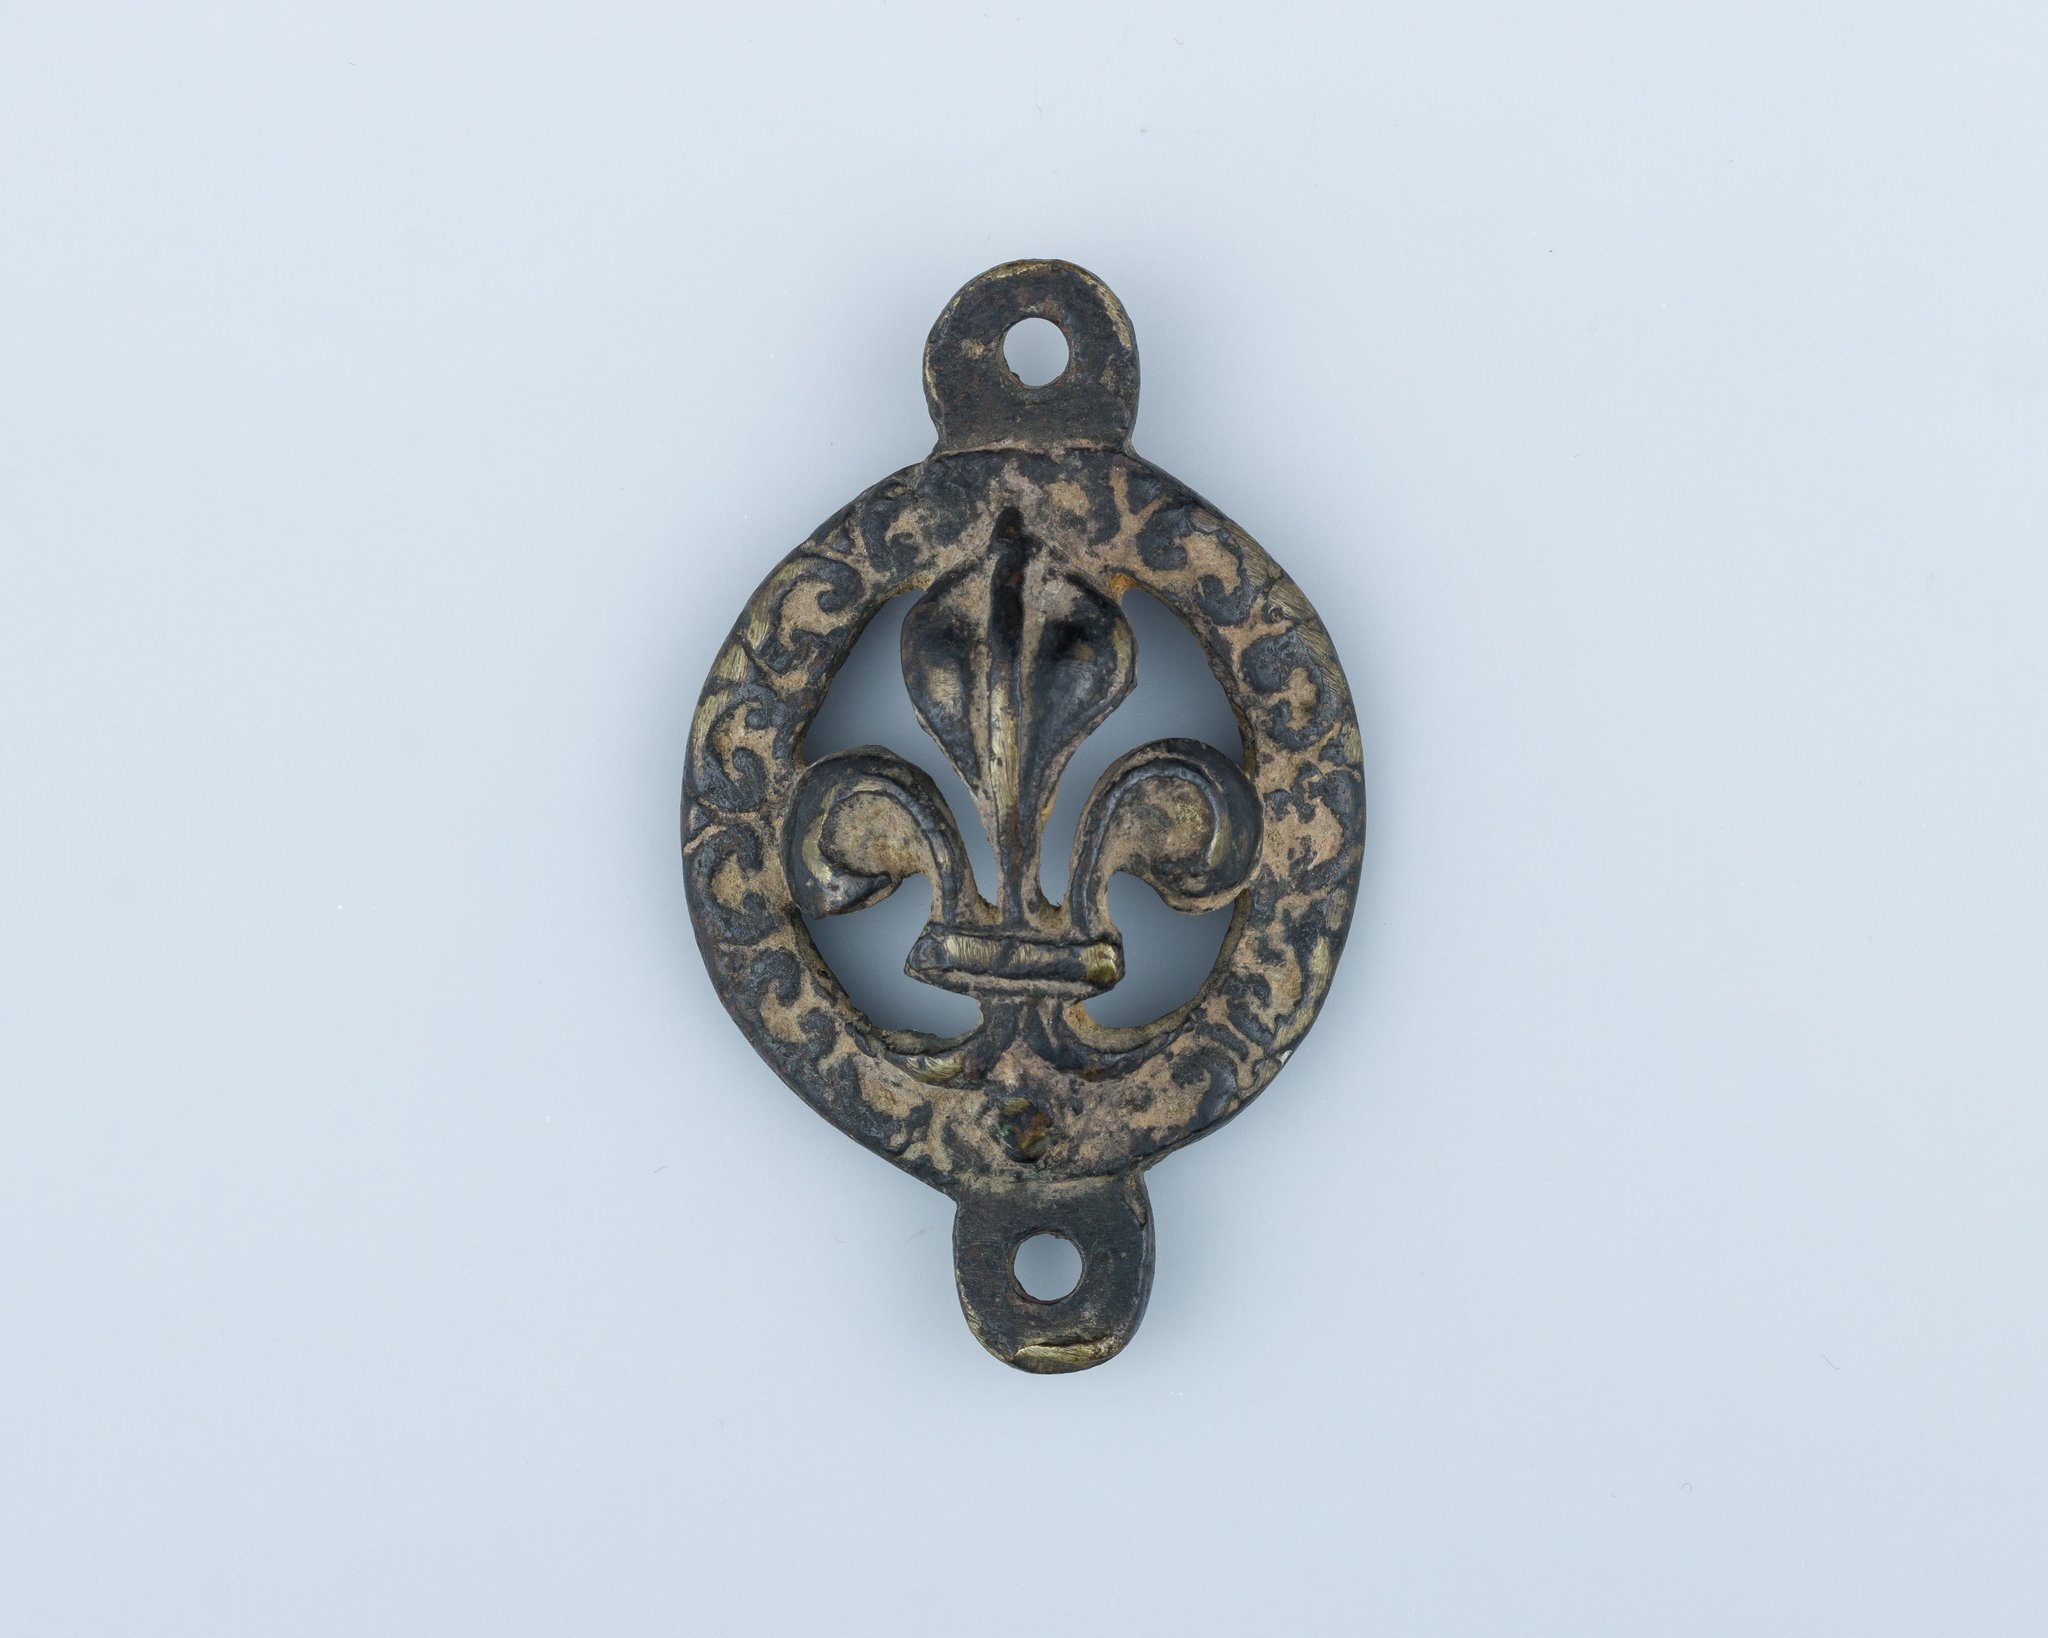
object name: belt ornament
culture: spanish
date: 1301-1400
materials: bronze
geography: spain